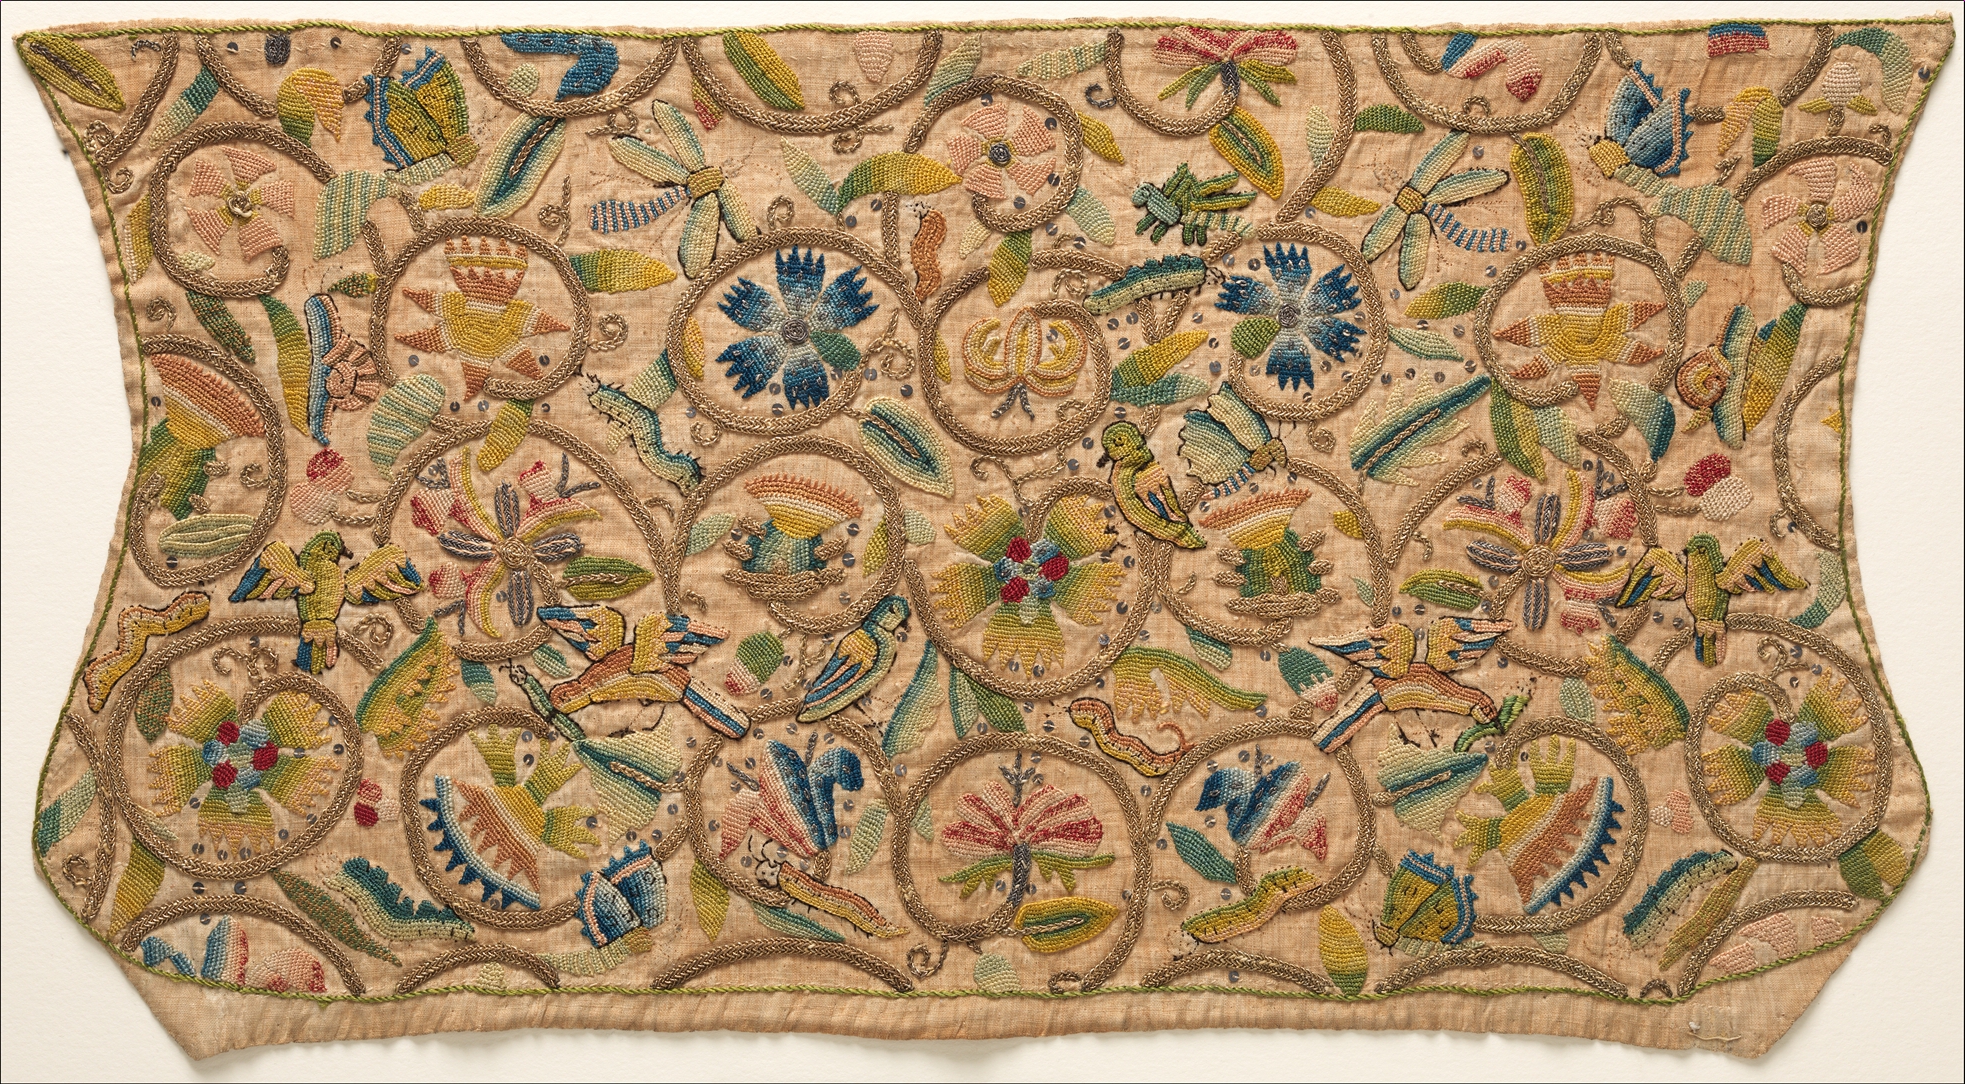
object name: coif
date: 1601-1633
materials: linen, silk, silver gilt, thread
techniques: embroidery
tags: birds,insects,dragonflies,flowers